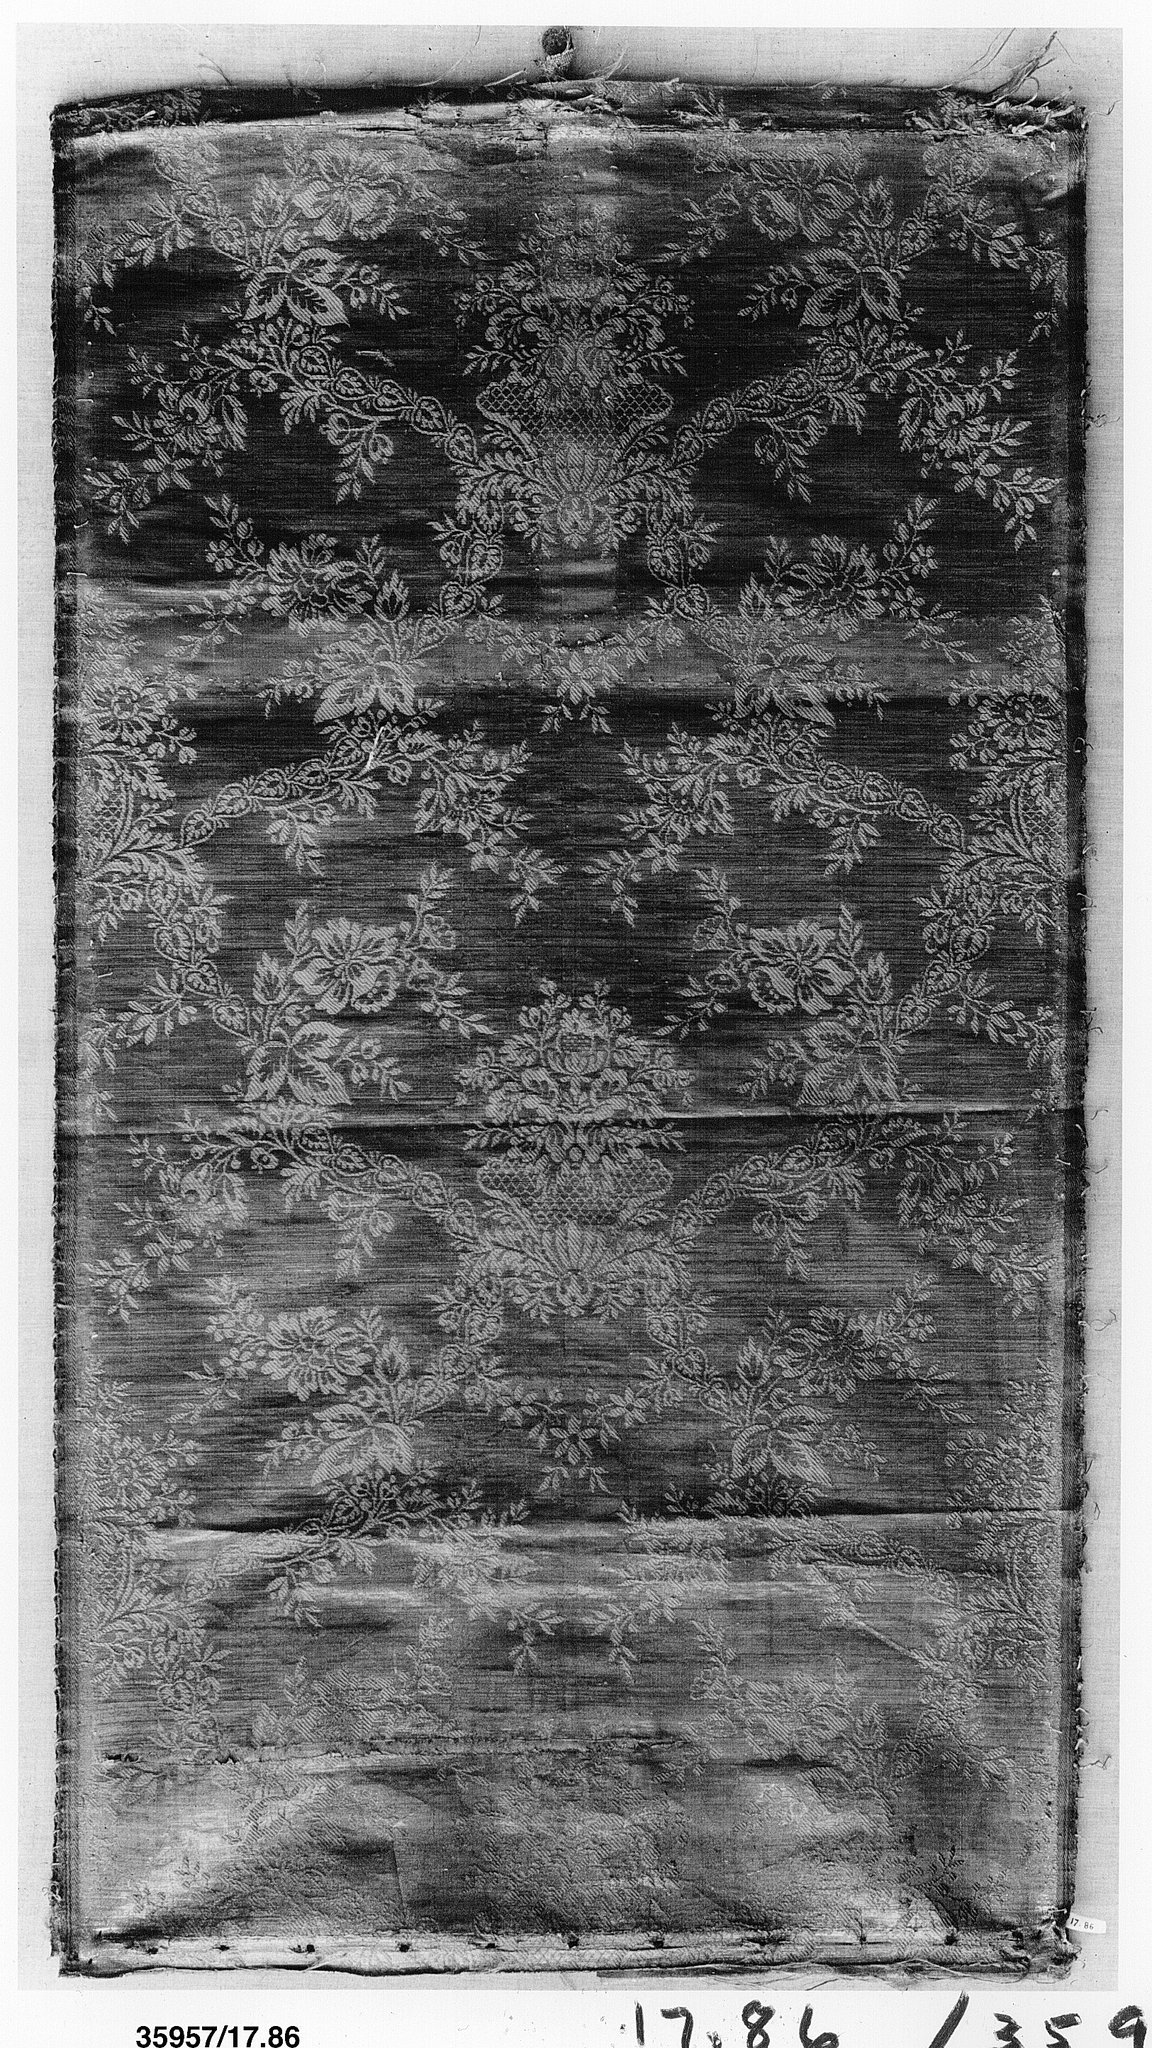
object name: piece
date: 1734-1766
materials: metal thread, silk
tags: flowers,leaves